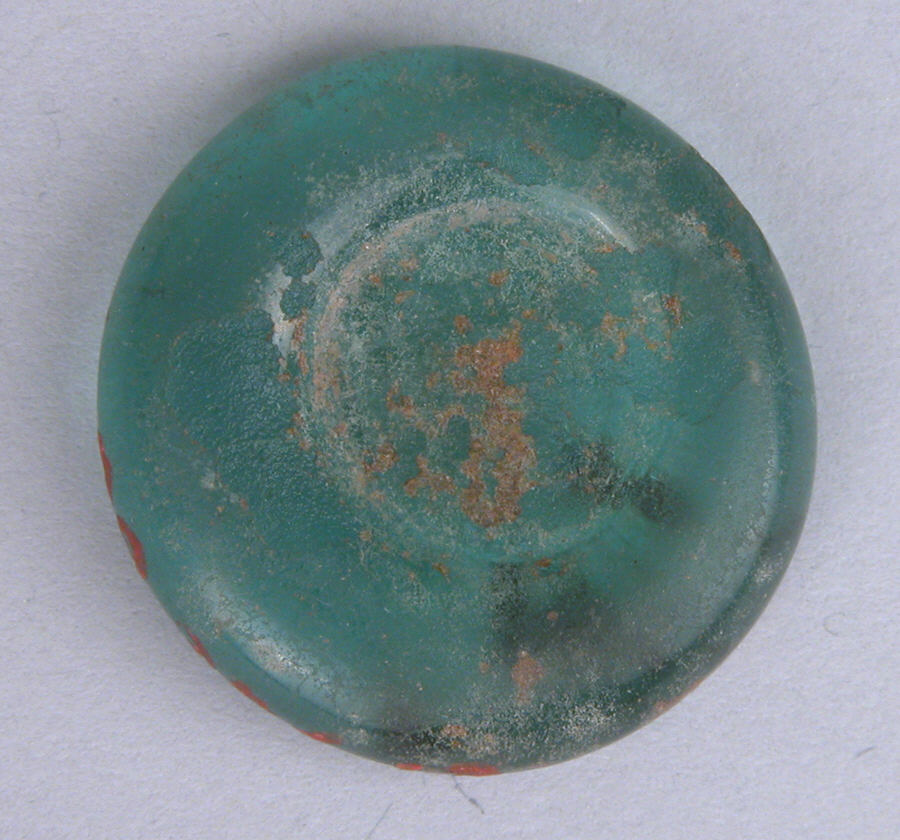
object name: coin weight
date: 901-1100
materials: glass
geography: egypt